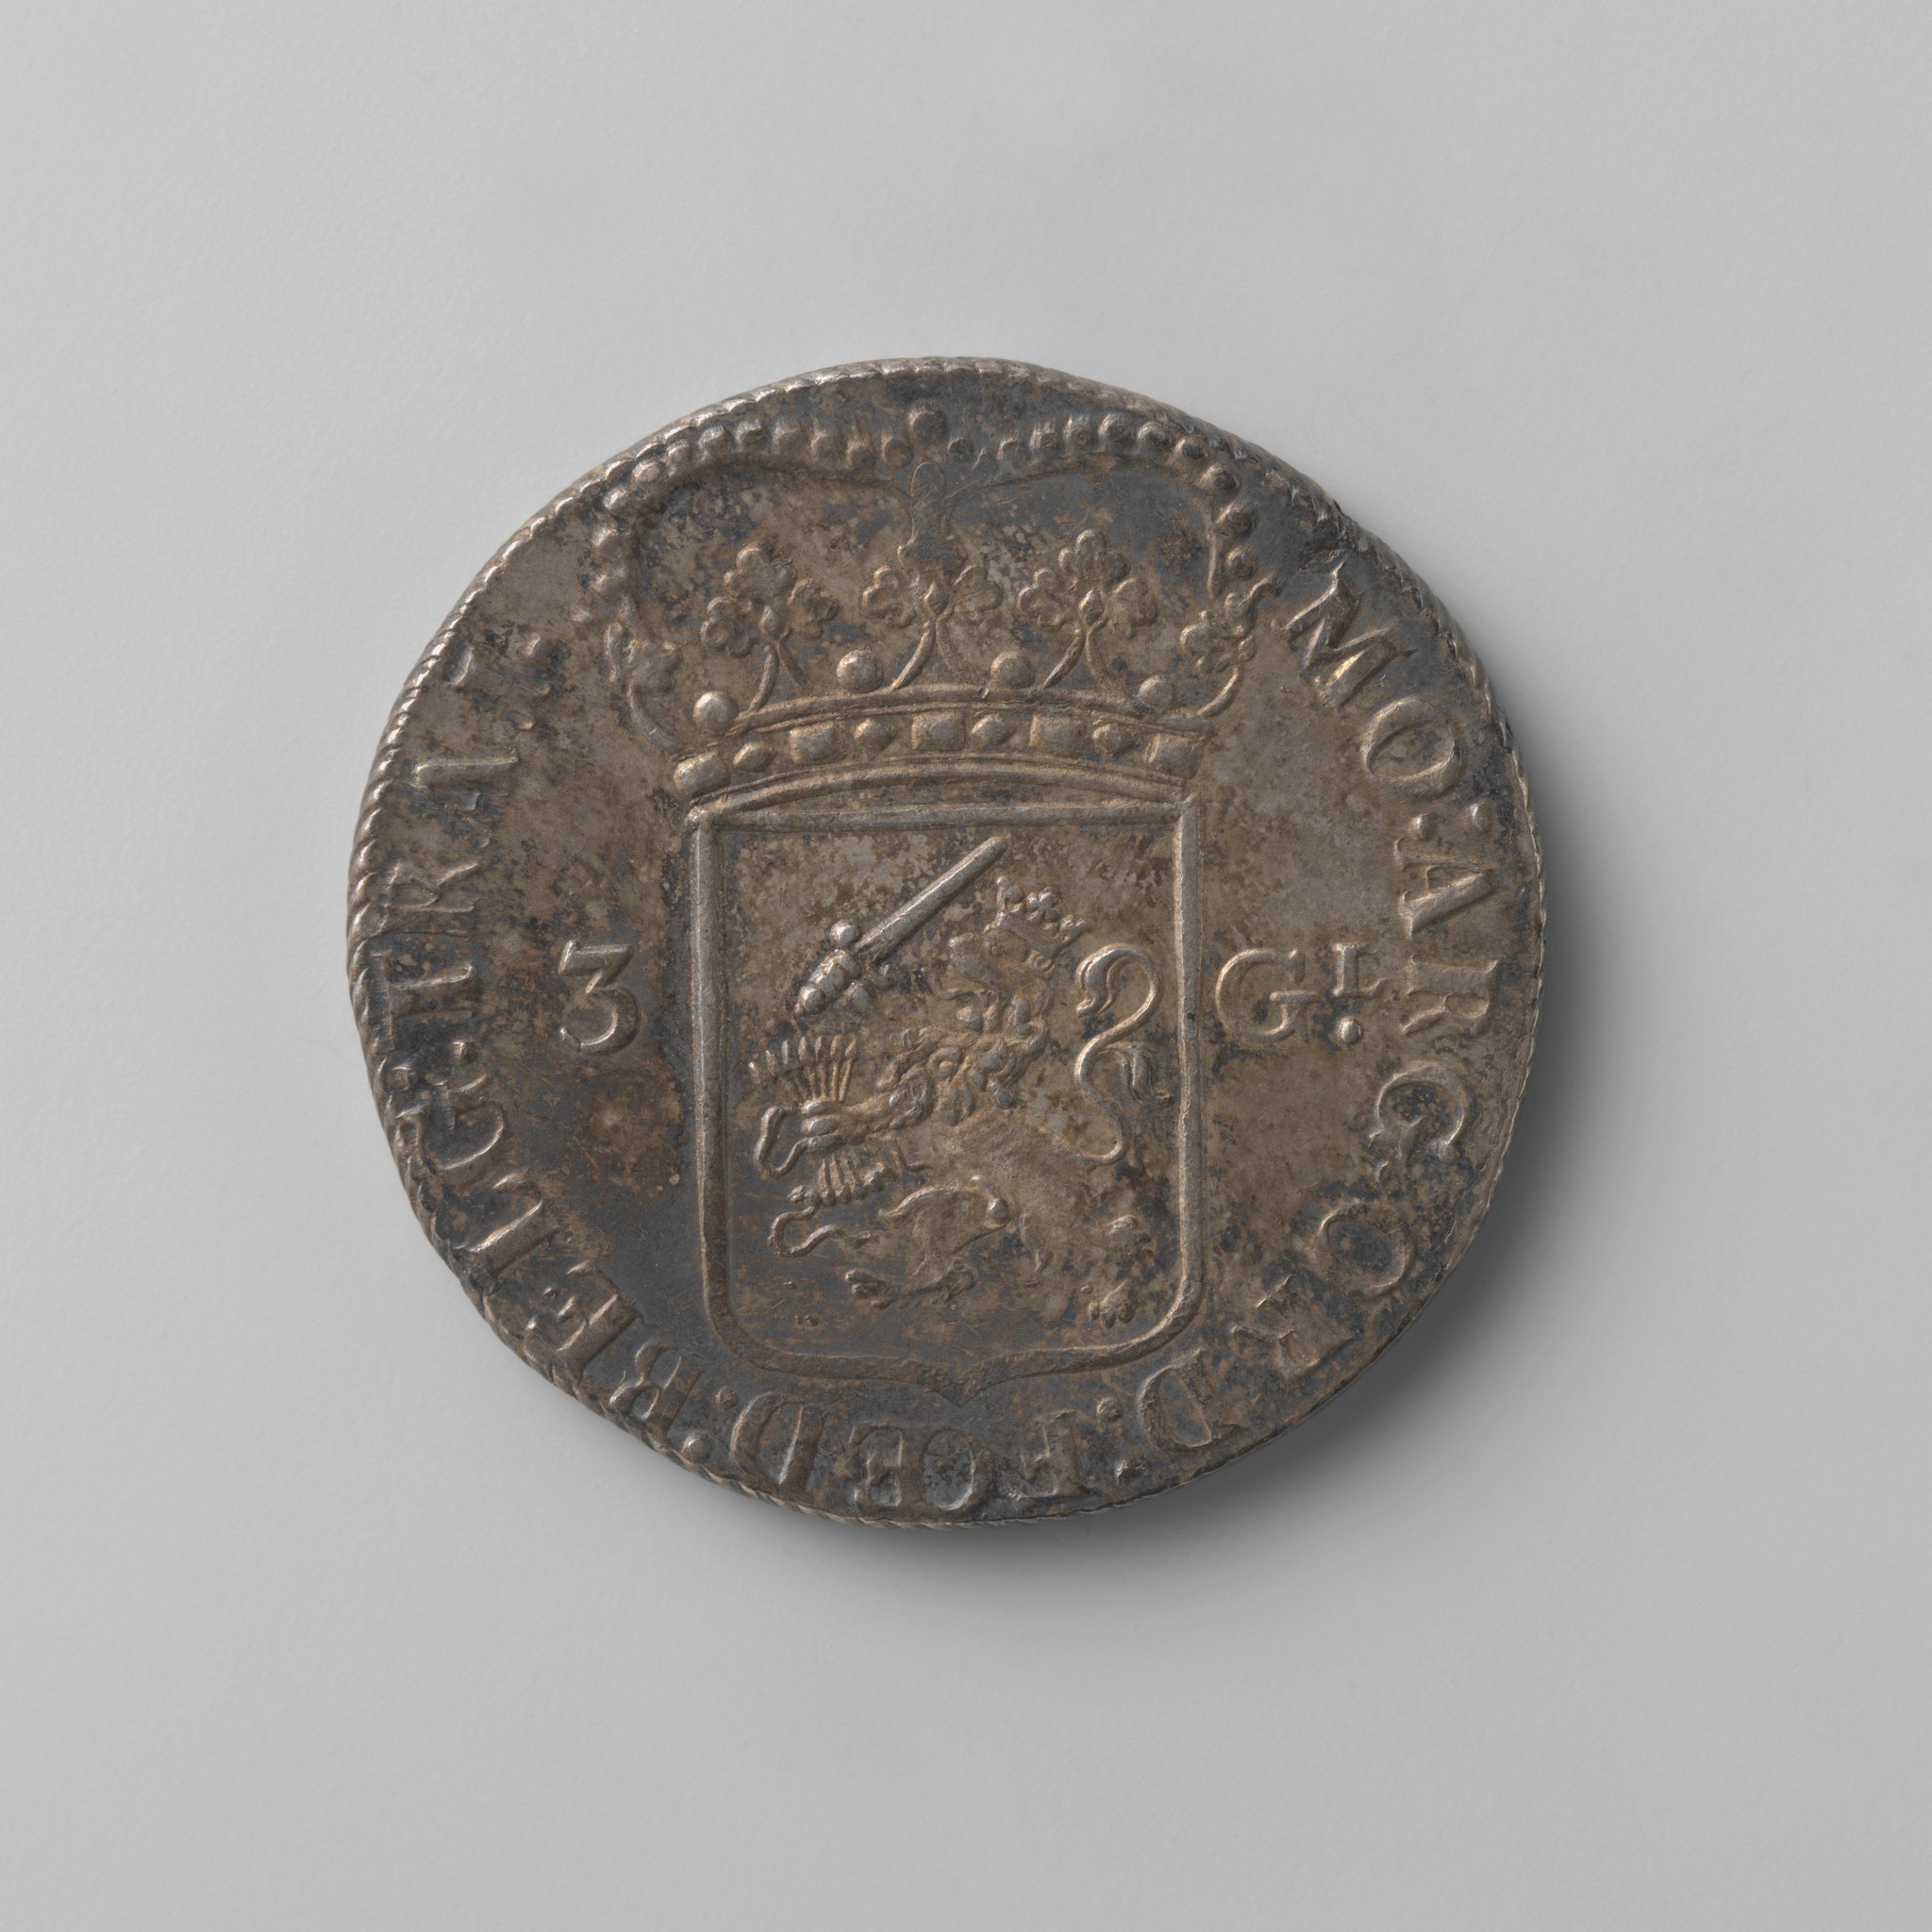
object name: coin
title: Utrechtse drie gulden, 1794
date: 1794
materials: silver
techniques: striking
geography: utrecht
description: Zilveren munt. Voorzijde: tussen waarde-aanduiding gekroond generaliteitswapenschild. Keerzijde: Nederlandse maagd met vrijheidshoed en speer, leunend op een bijbel op een altaar. In afsnede jaartal. Kabelrand.